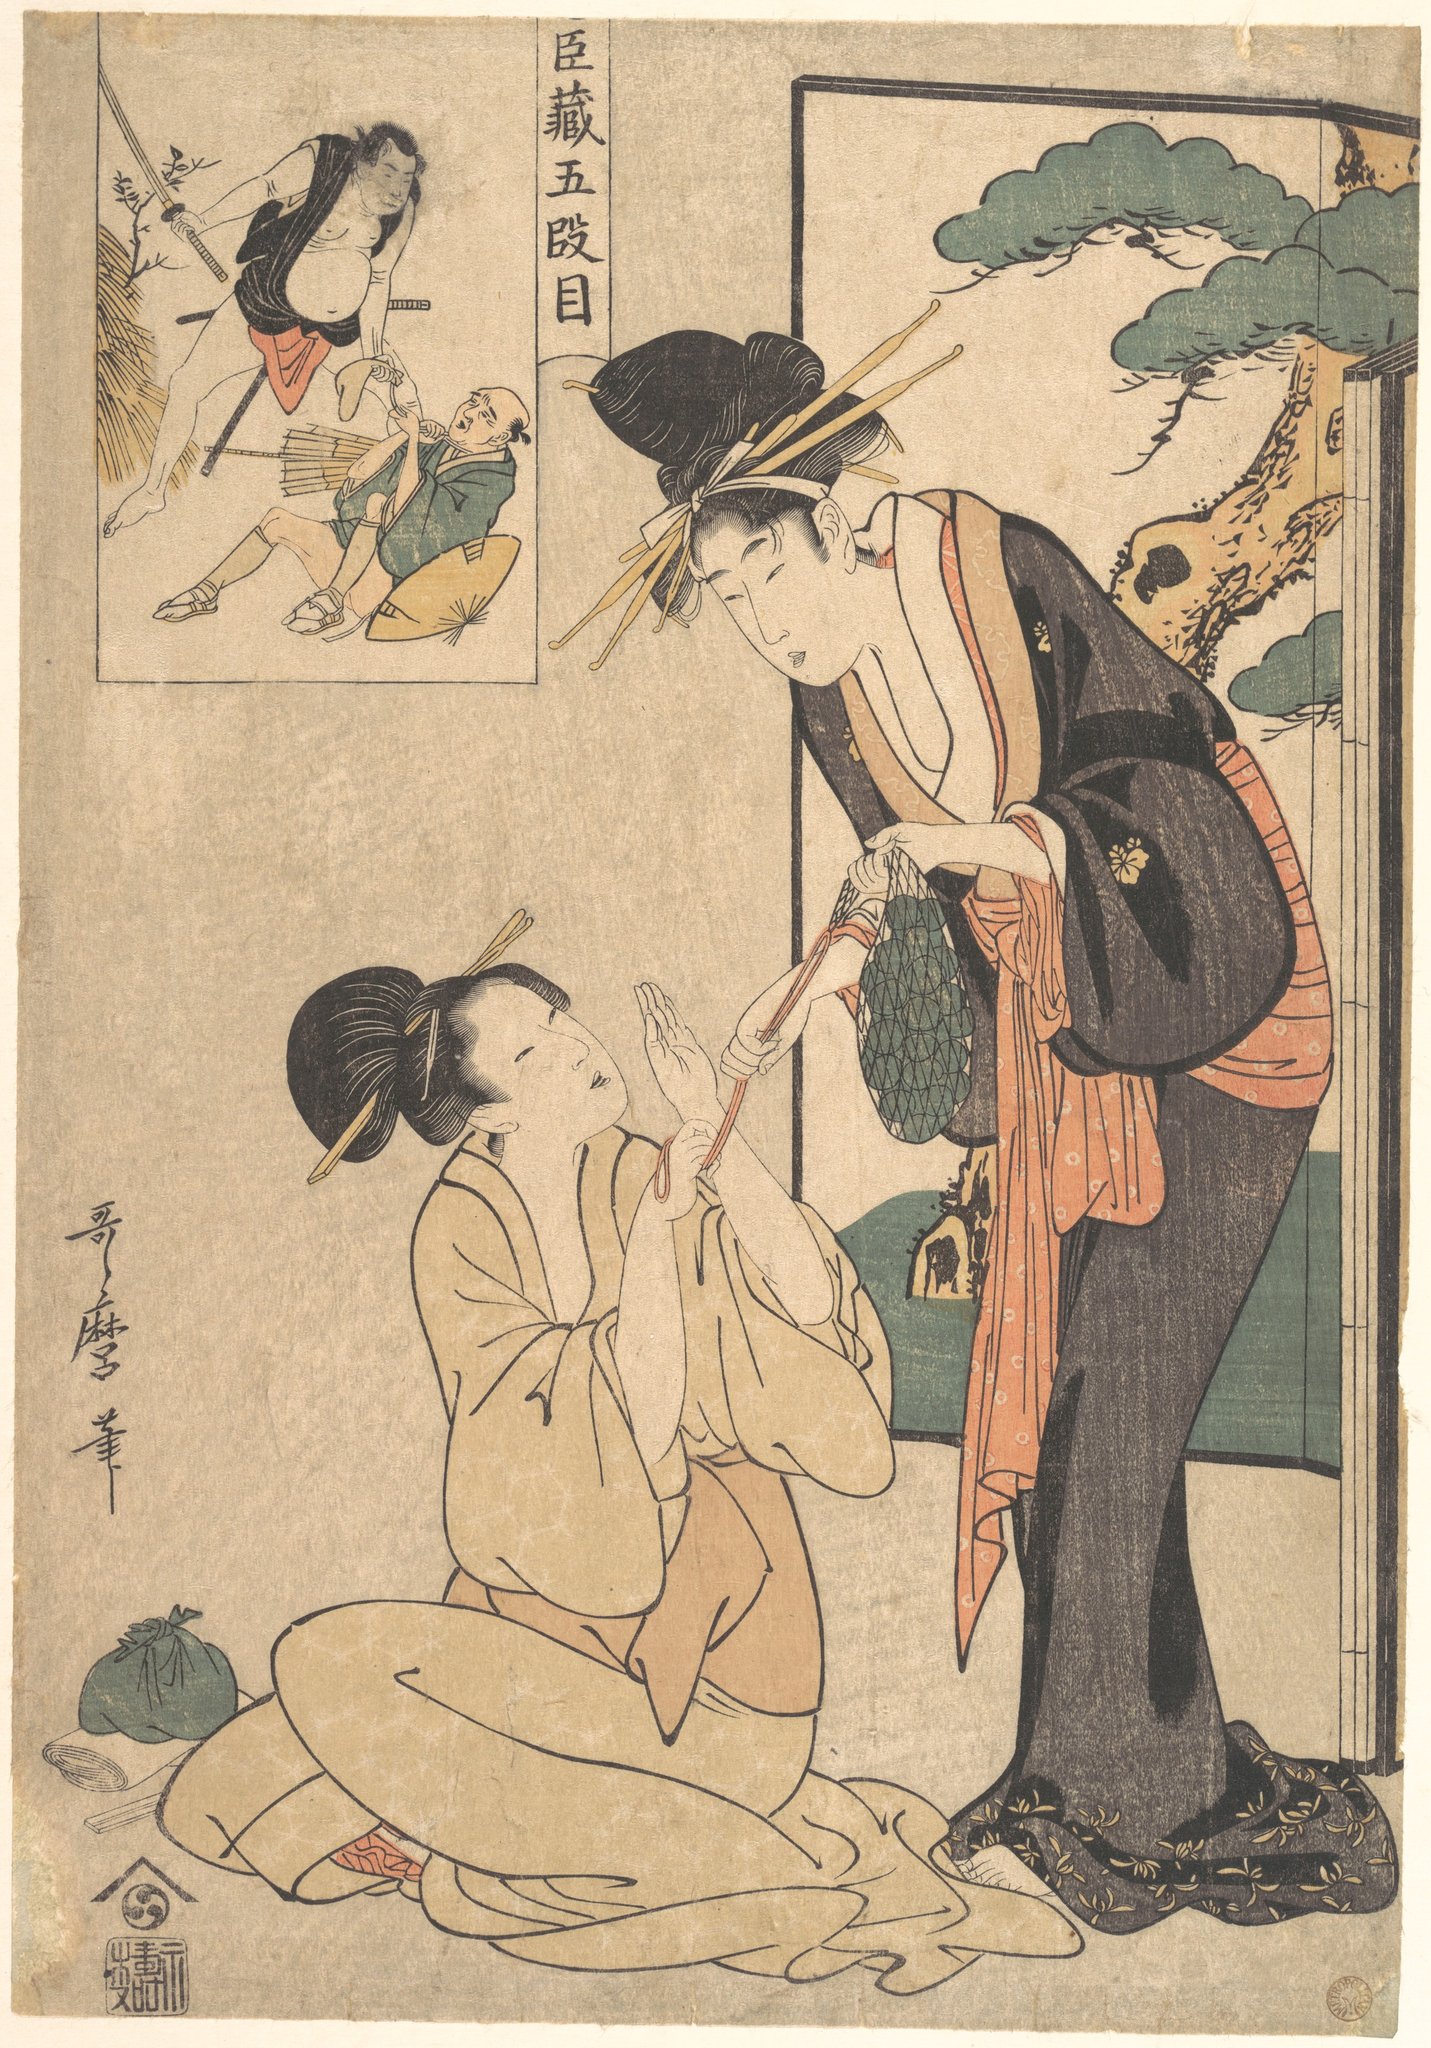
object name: print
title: A Woman Snatching a Bag of Sweetmeats from Her MotHer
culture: japanese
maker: kitagawa utamaro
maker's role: artist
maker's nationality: japanese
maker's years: 1754-1806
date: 1754-1806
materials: ink, paper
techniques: woodblock print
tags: men,women